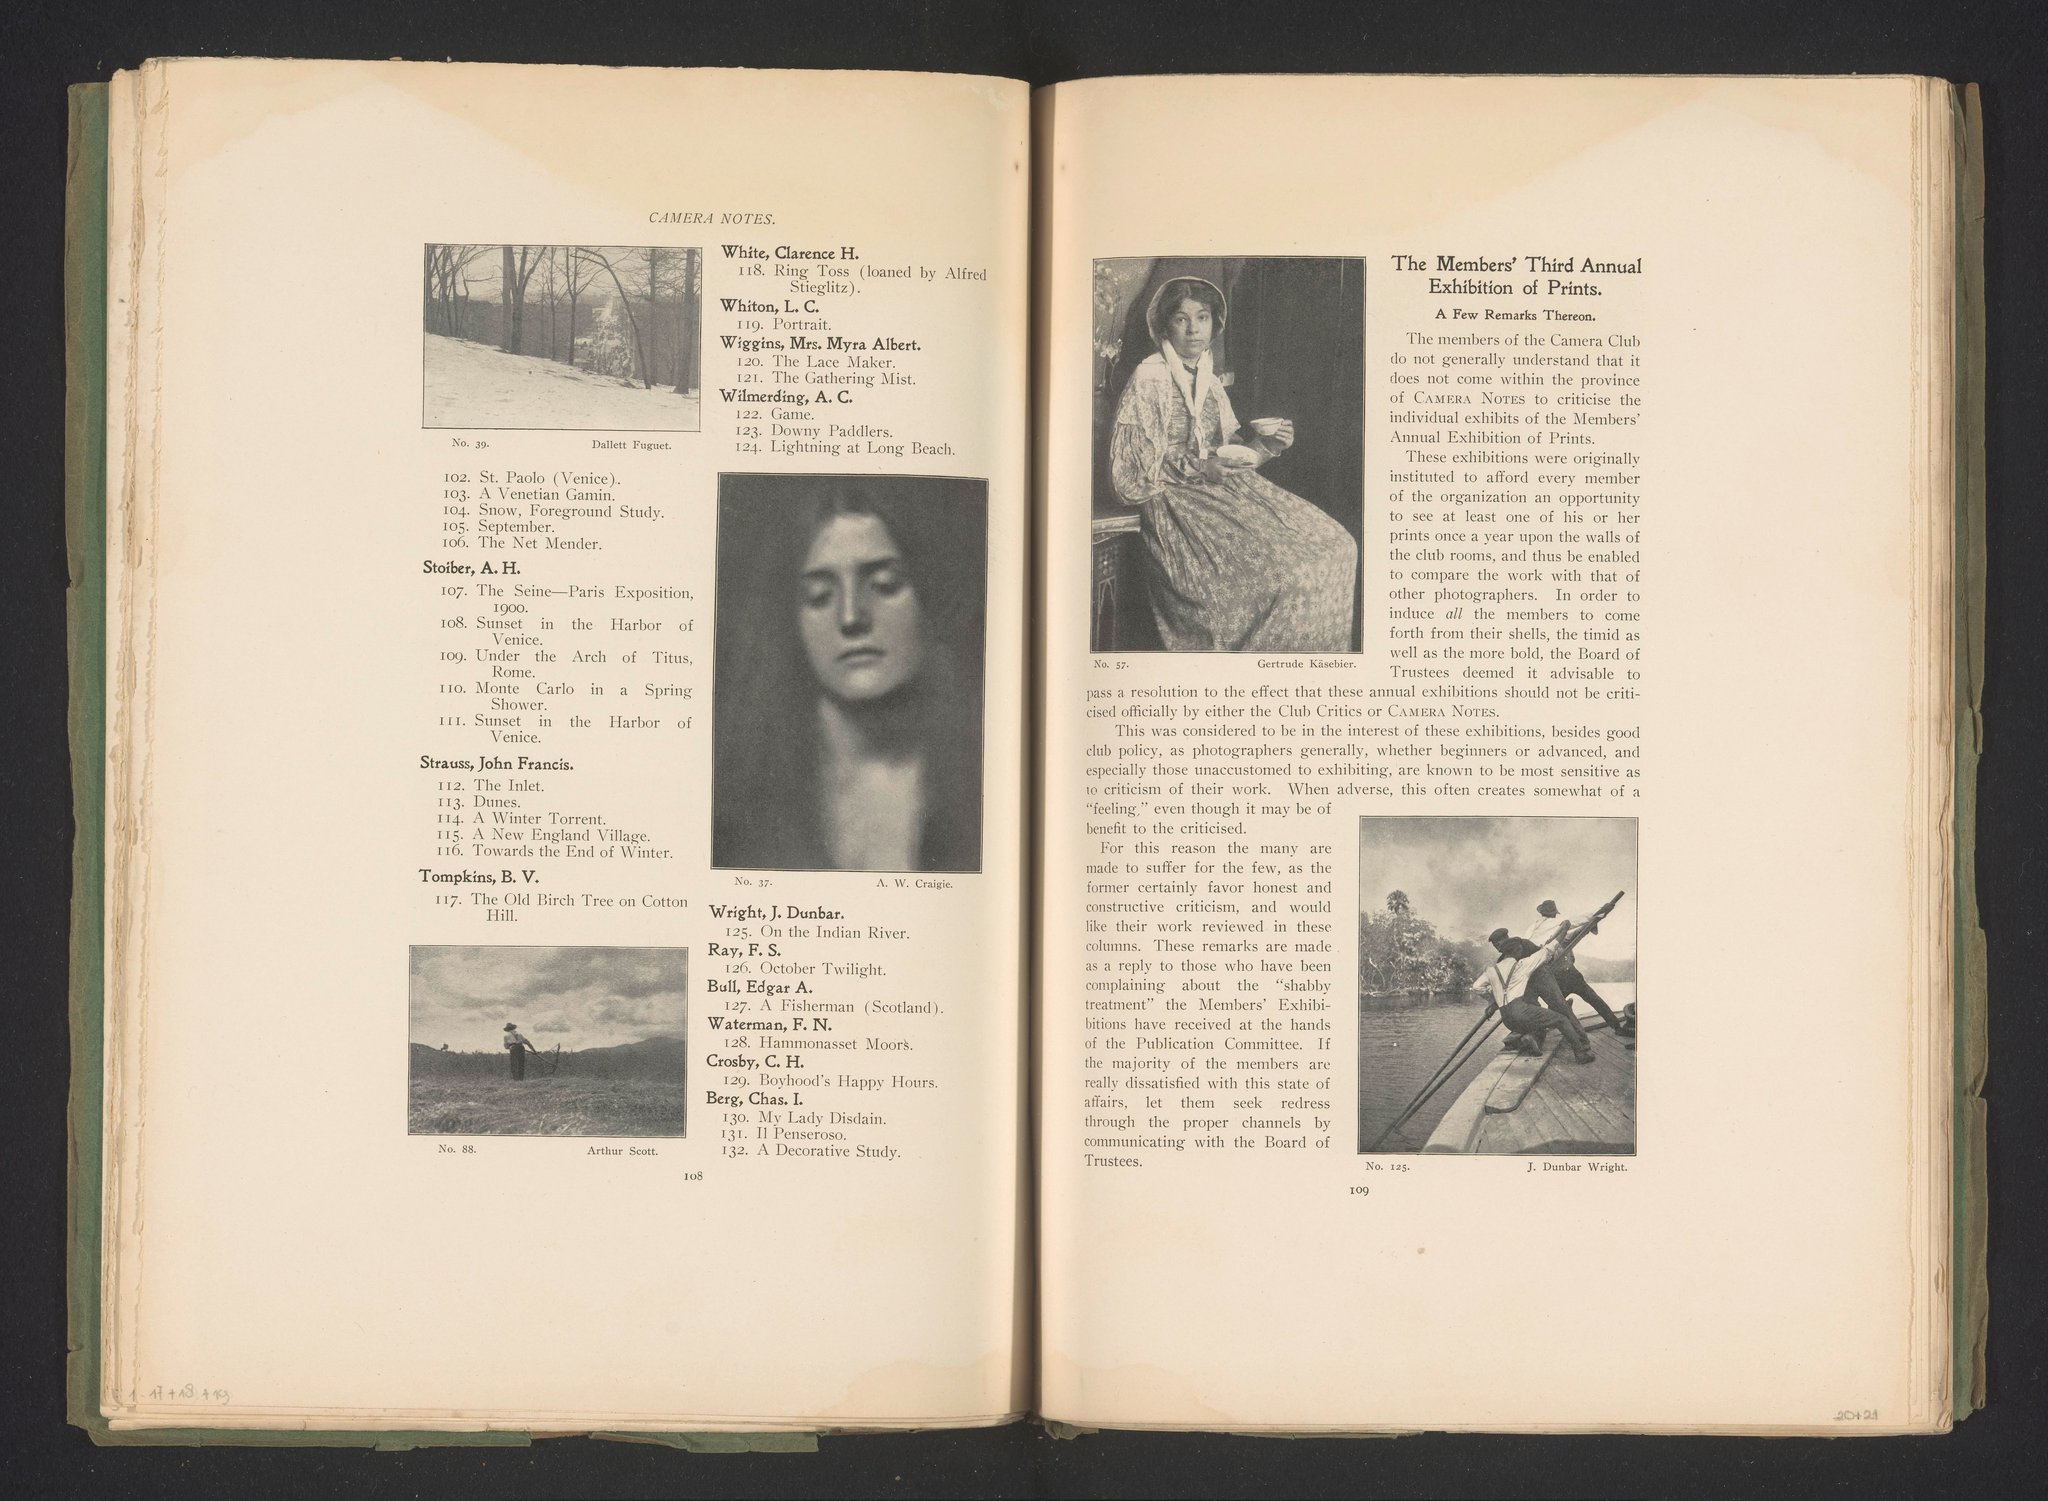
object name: photomechanical print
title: Portret van een onbekende vrouw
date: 1895-1900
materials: paper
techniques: autotype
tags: historical persons not known by name - bb - woman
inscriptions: number: ‘No. 57’